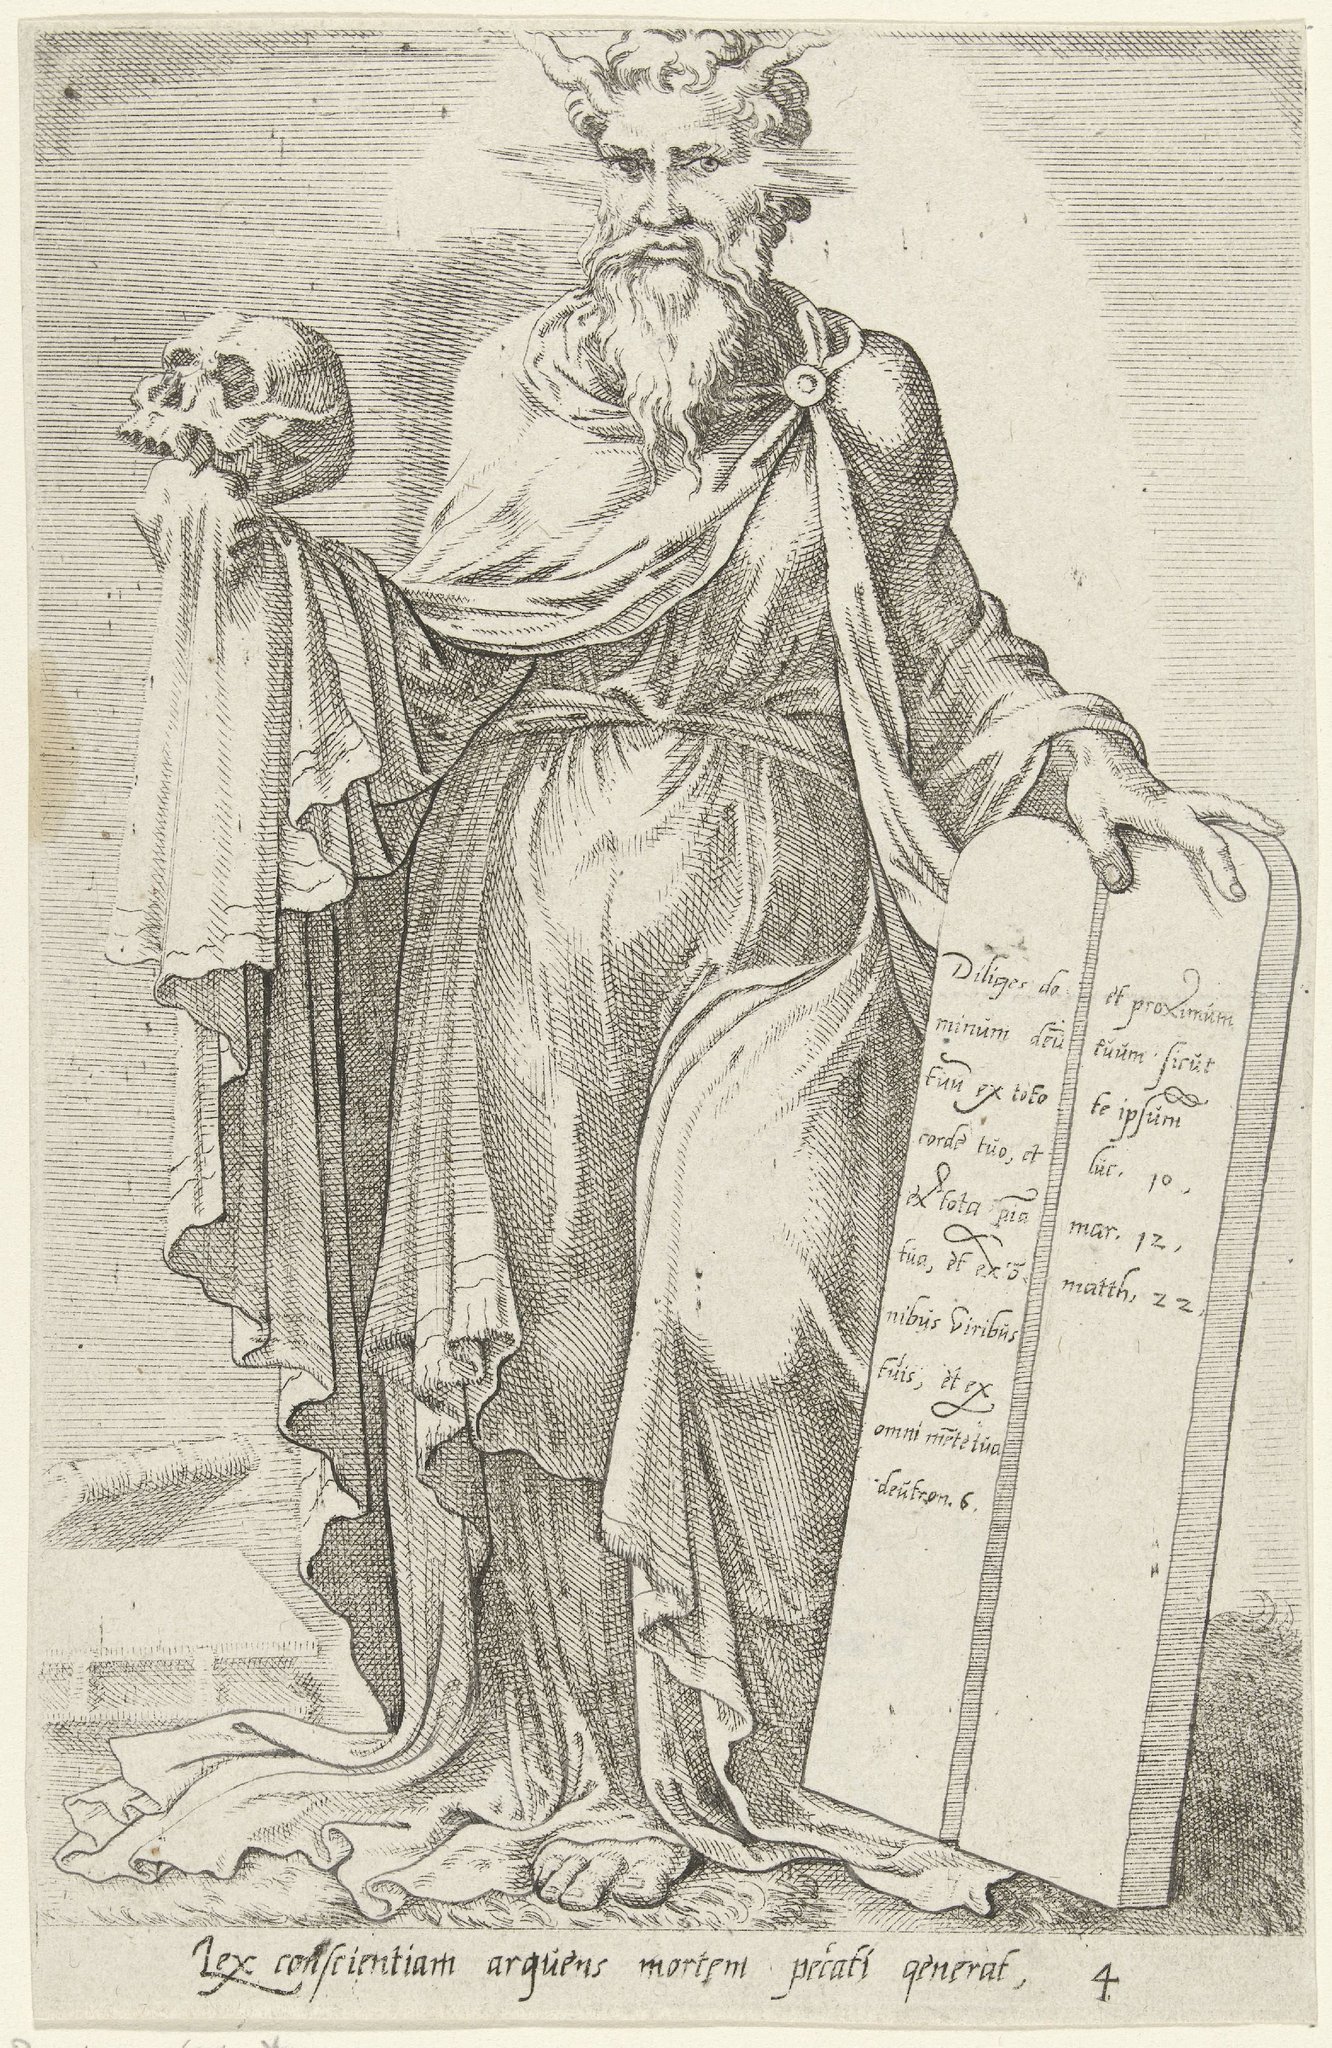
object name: print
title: Jakobs ladder of de allegorie van de weg naar eeuwige zaligheid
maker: dirck volckertsz. coornhert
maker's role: draughtsman, print maker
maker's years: 1522-1590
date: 1550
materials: paper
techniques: etching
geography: haarlem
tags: moses (not in biblical context); possible attributes: rays of light or horns on his head, rod, tables of the law, the ten commandments represented together on stone tablets, eternal bliss; 'felicità eterna' (ripa) (+ symbolical representation of concept), death's head, skull (symbol of death)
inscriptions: collector's mark: Lugt 2228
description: Mozes met in zijn rechterhand een schedel (de dood) en in zijn linkerhand de stenen tafel met de tien geboden. De prent heeft een Latijns onderschrift en maakt deel uit van een veertiendelige serie met als onderwerp de manier om eeuwige zaligheid te bereiken.